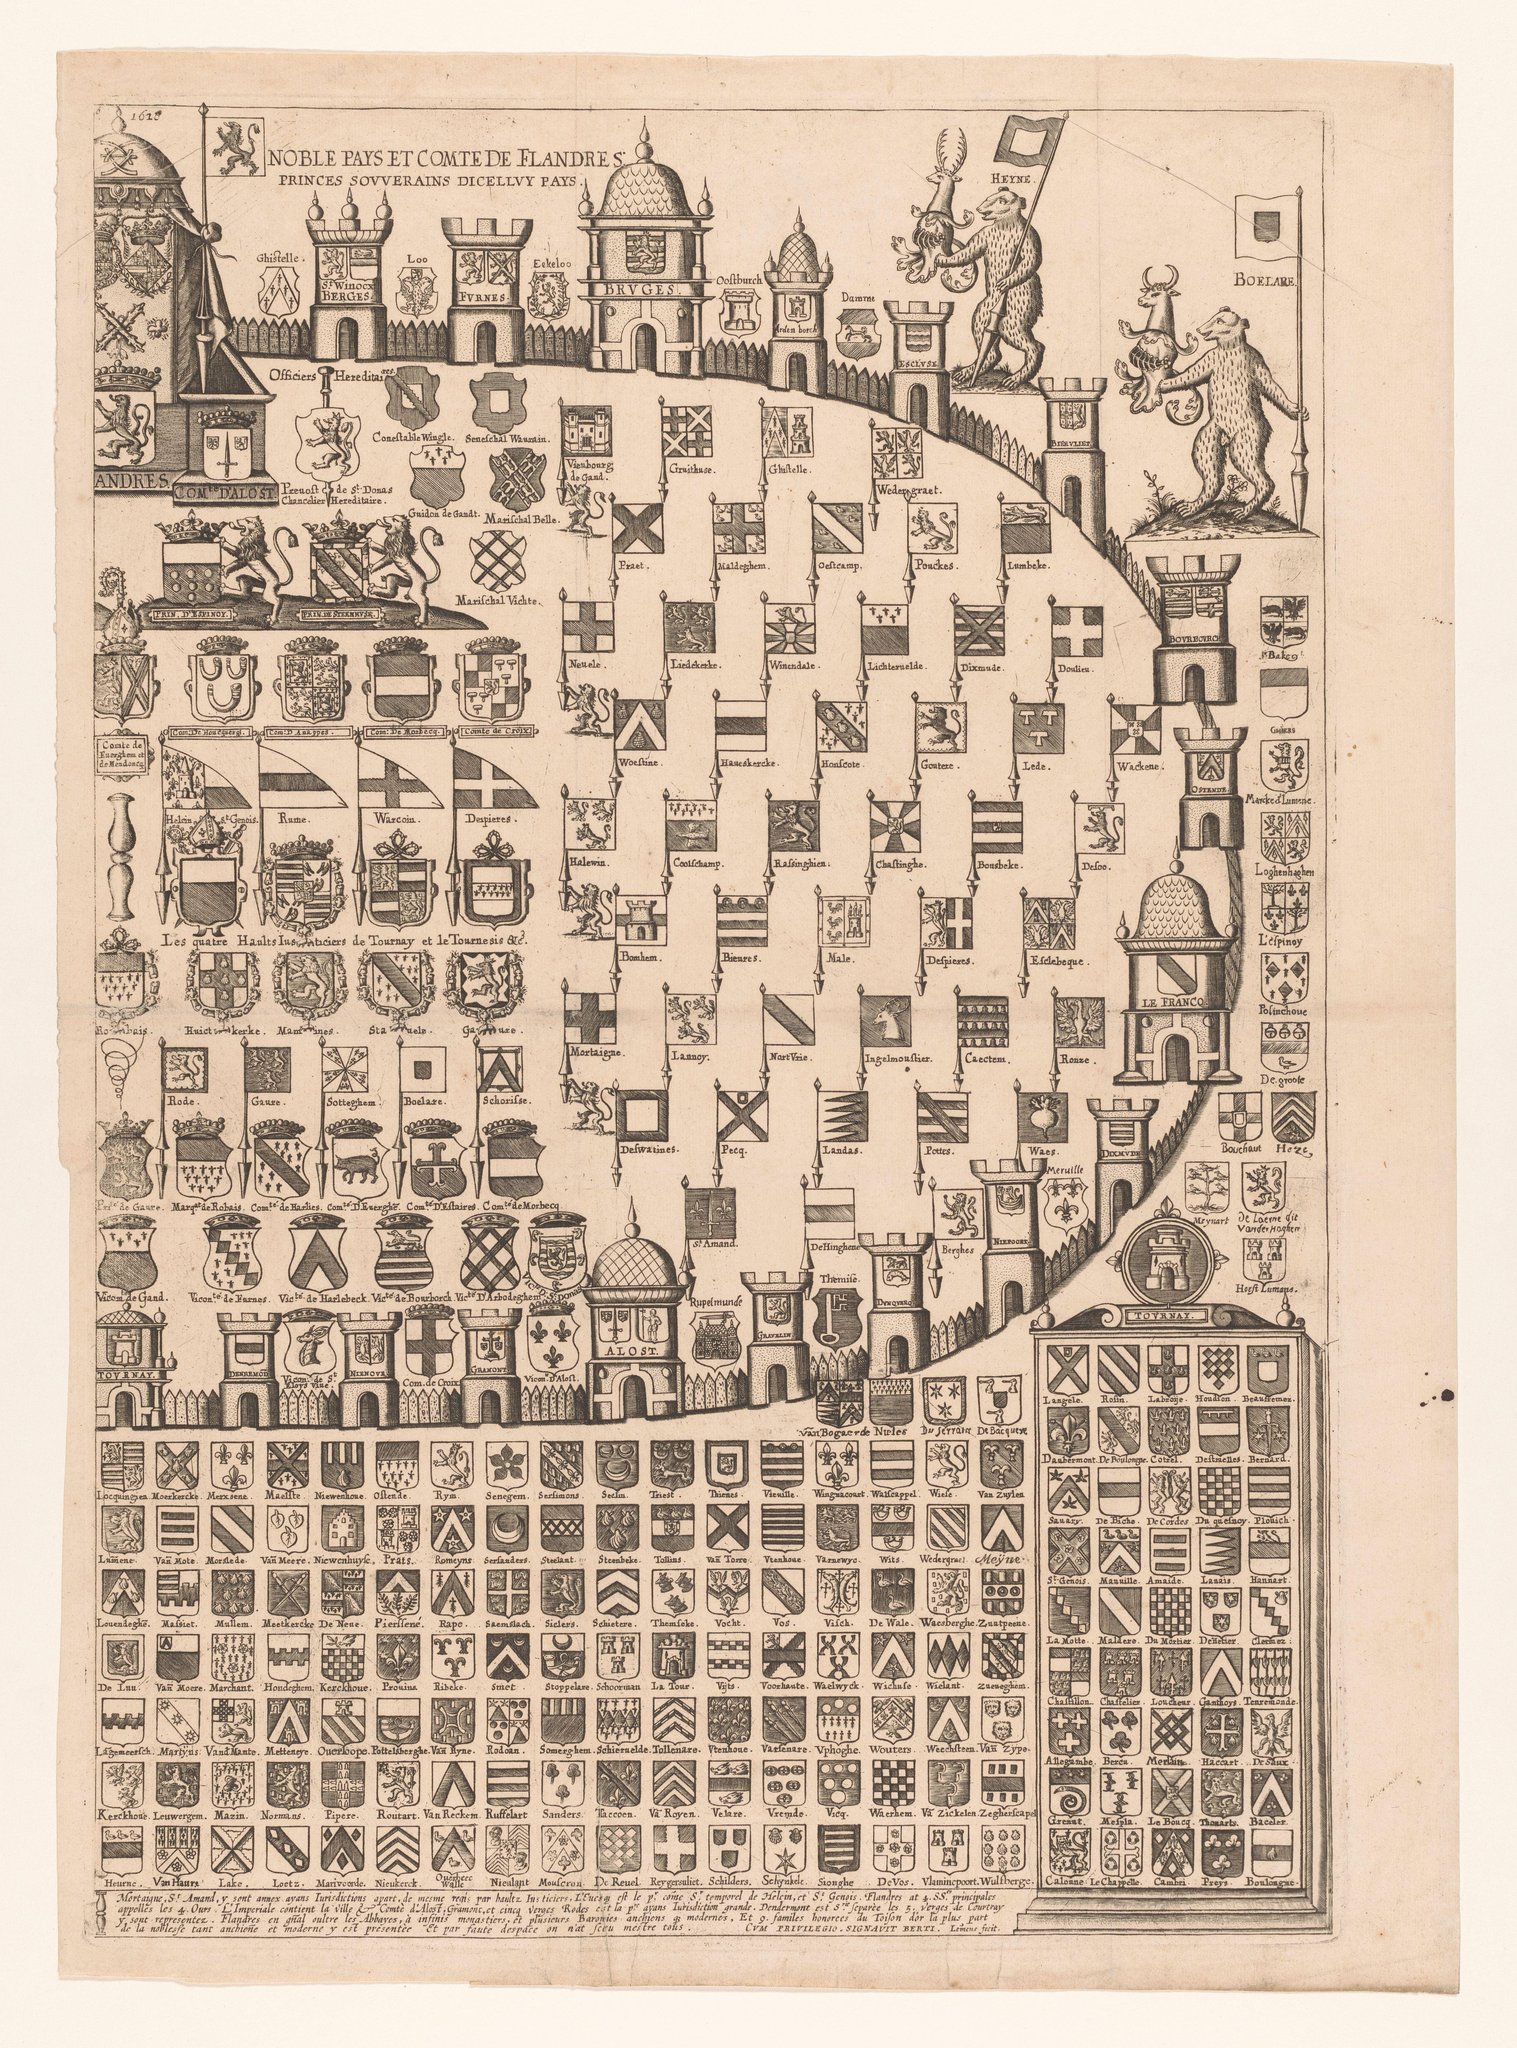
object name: print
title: Representation des estats du noble pays et comte de Flandres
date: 1618-1628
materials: paper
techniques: engraving, etching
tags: coat of arms (as symbol of the state, etc.)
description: Wapenkaart van het graafschap Vlaanderen. Onderdeel van de Zuidelijke Nederlanden onder bestuur van de landvoogden Albrecht (Albert) en Isabella (Elisabeth). Buiten de omheining staan vier beren met banieren. In twee delen, dit is het rechter blad.